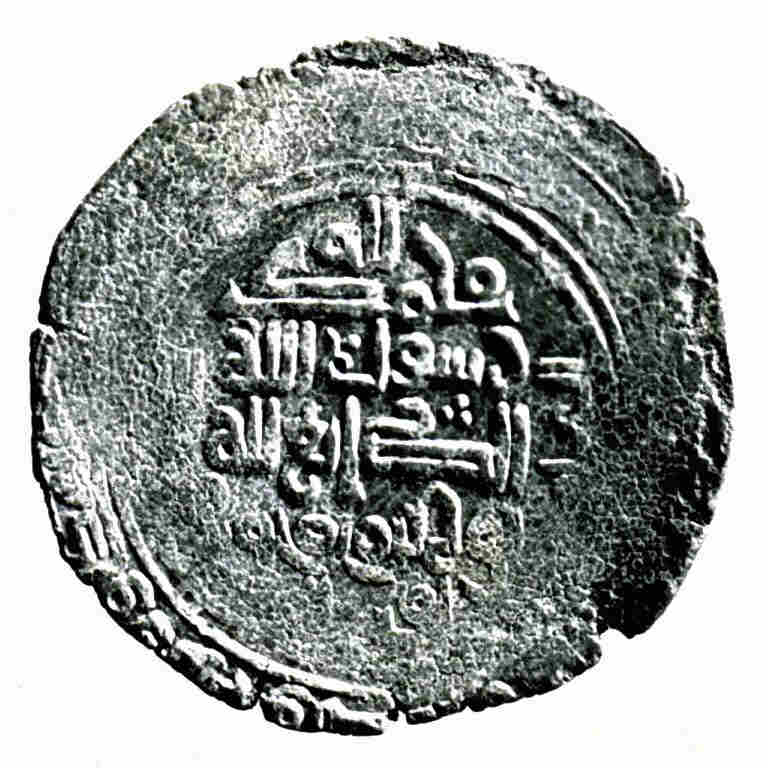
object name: coin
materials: silver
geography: iran